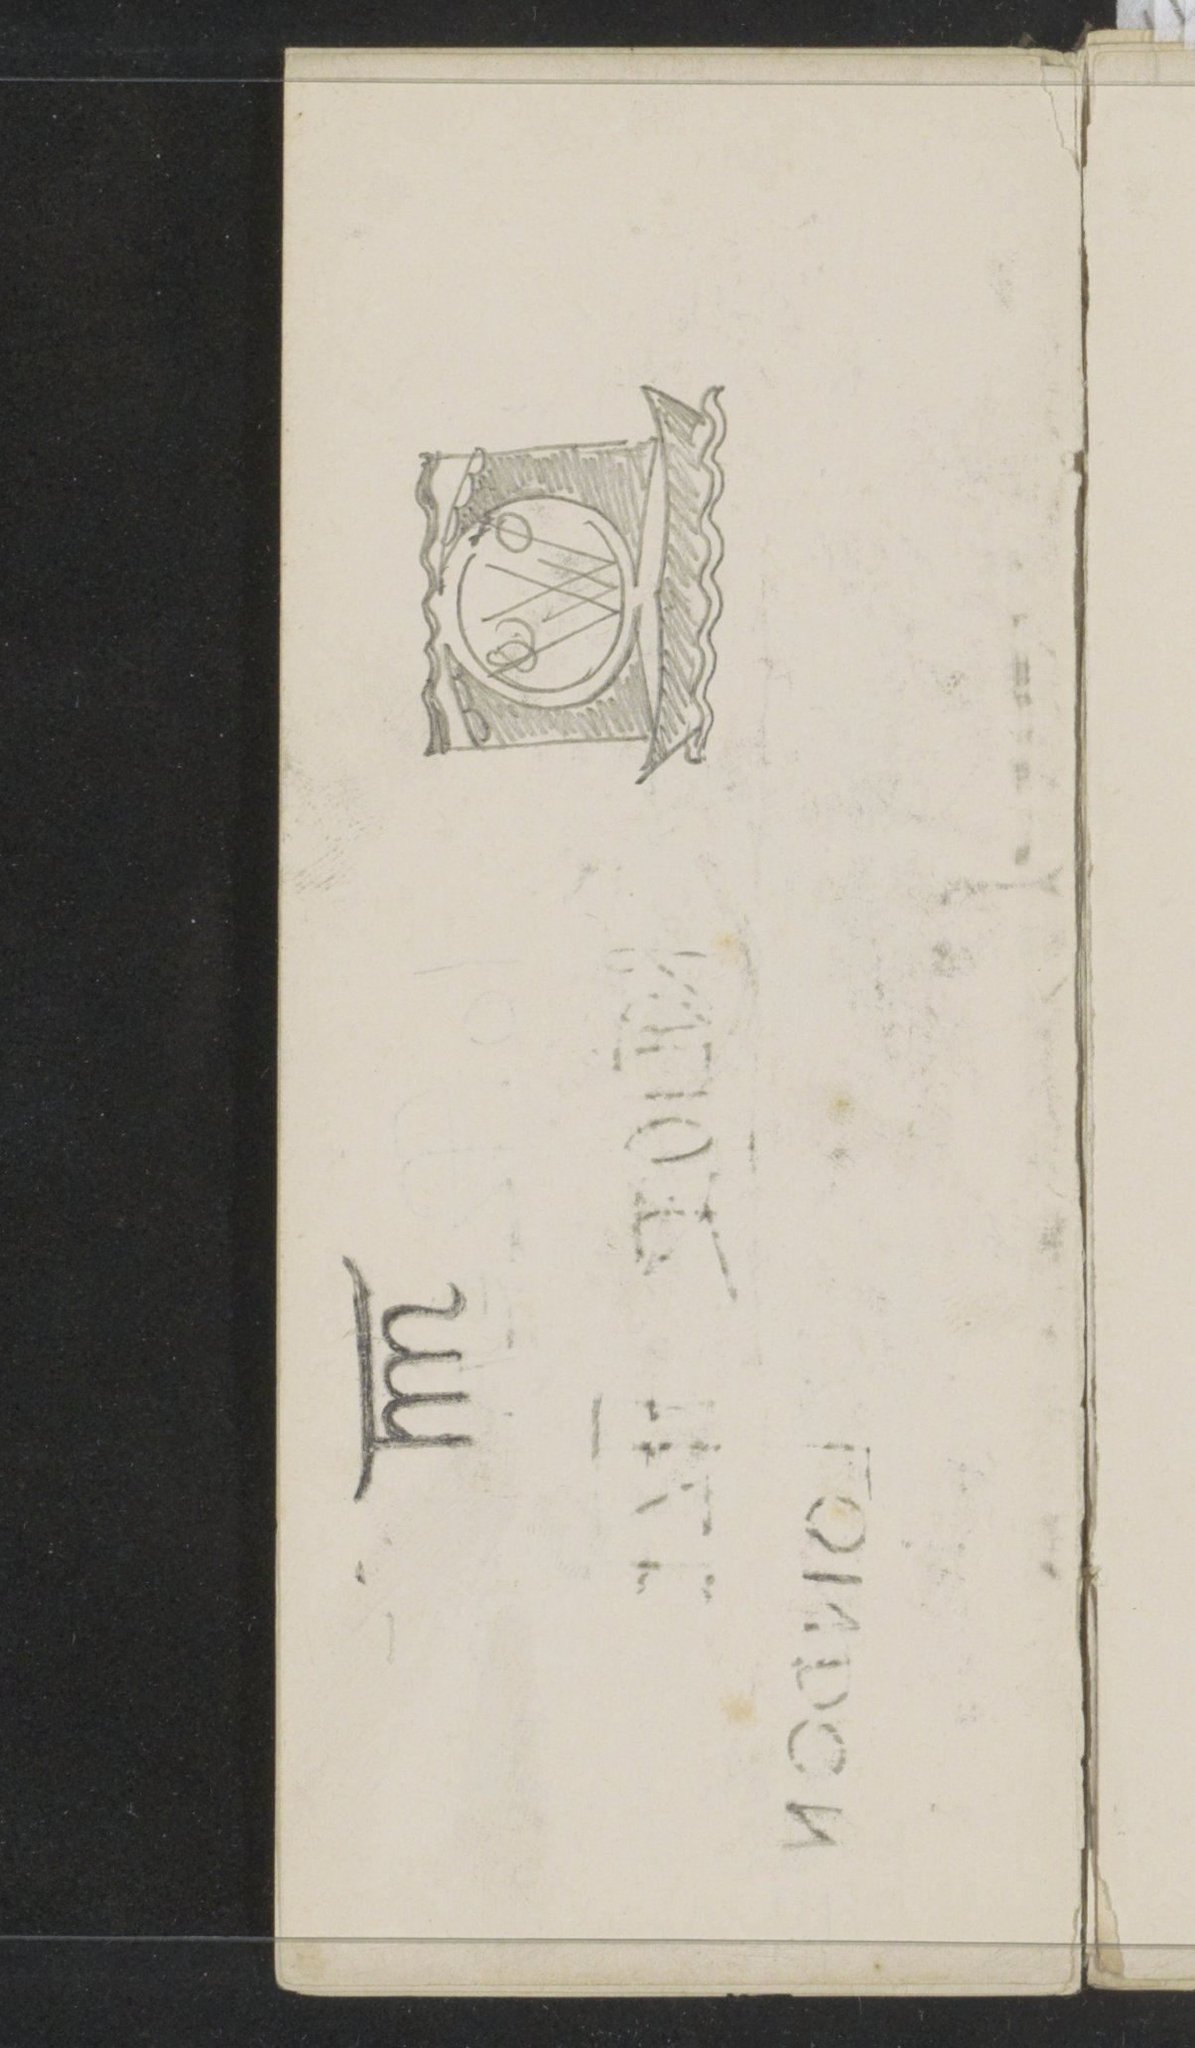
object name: sketchbook leaf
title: Ontwerp voor een monogram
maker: gerrit willem dijsselhof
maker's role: designer, draughtsman, print maker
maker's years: 1866-1924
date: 1901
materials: paper, pencil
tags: letter combinations such as letterword, anagram, letter square, monogram, etc.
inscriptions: annotation: ‘WW/ nm?’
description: Cirkel met het monogram boven een boot op een zee met golven. Blad 3 verso uit een schetsboek met 42 bladzijden.